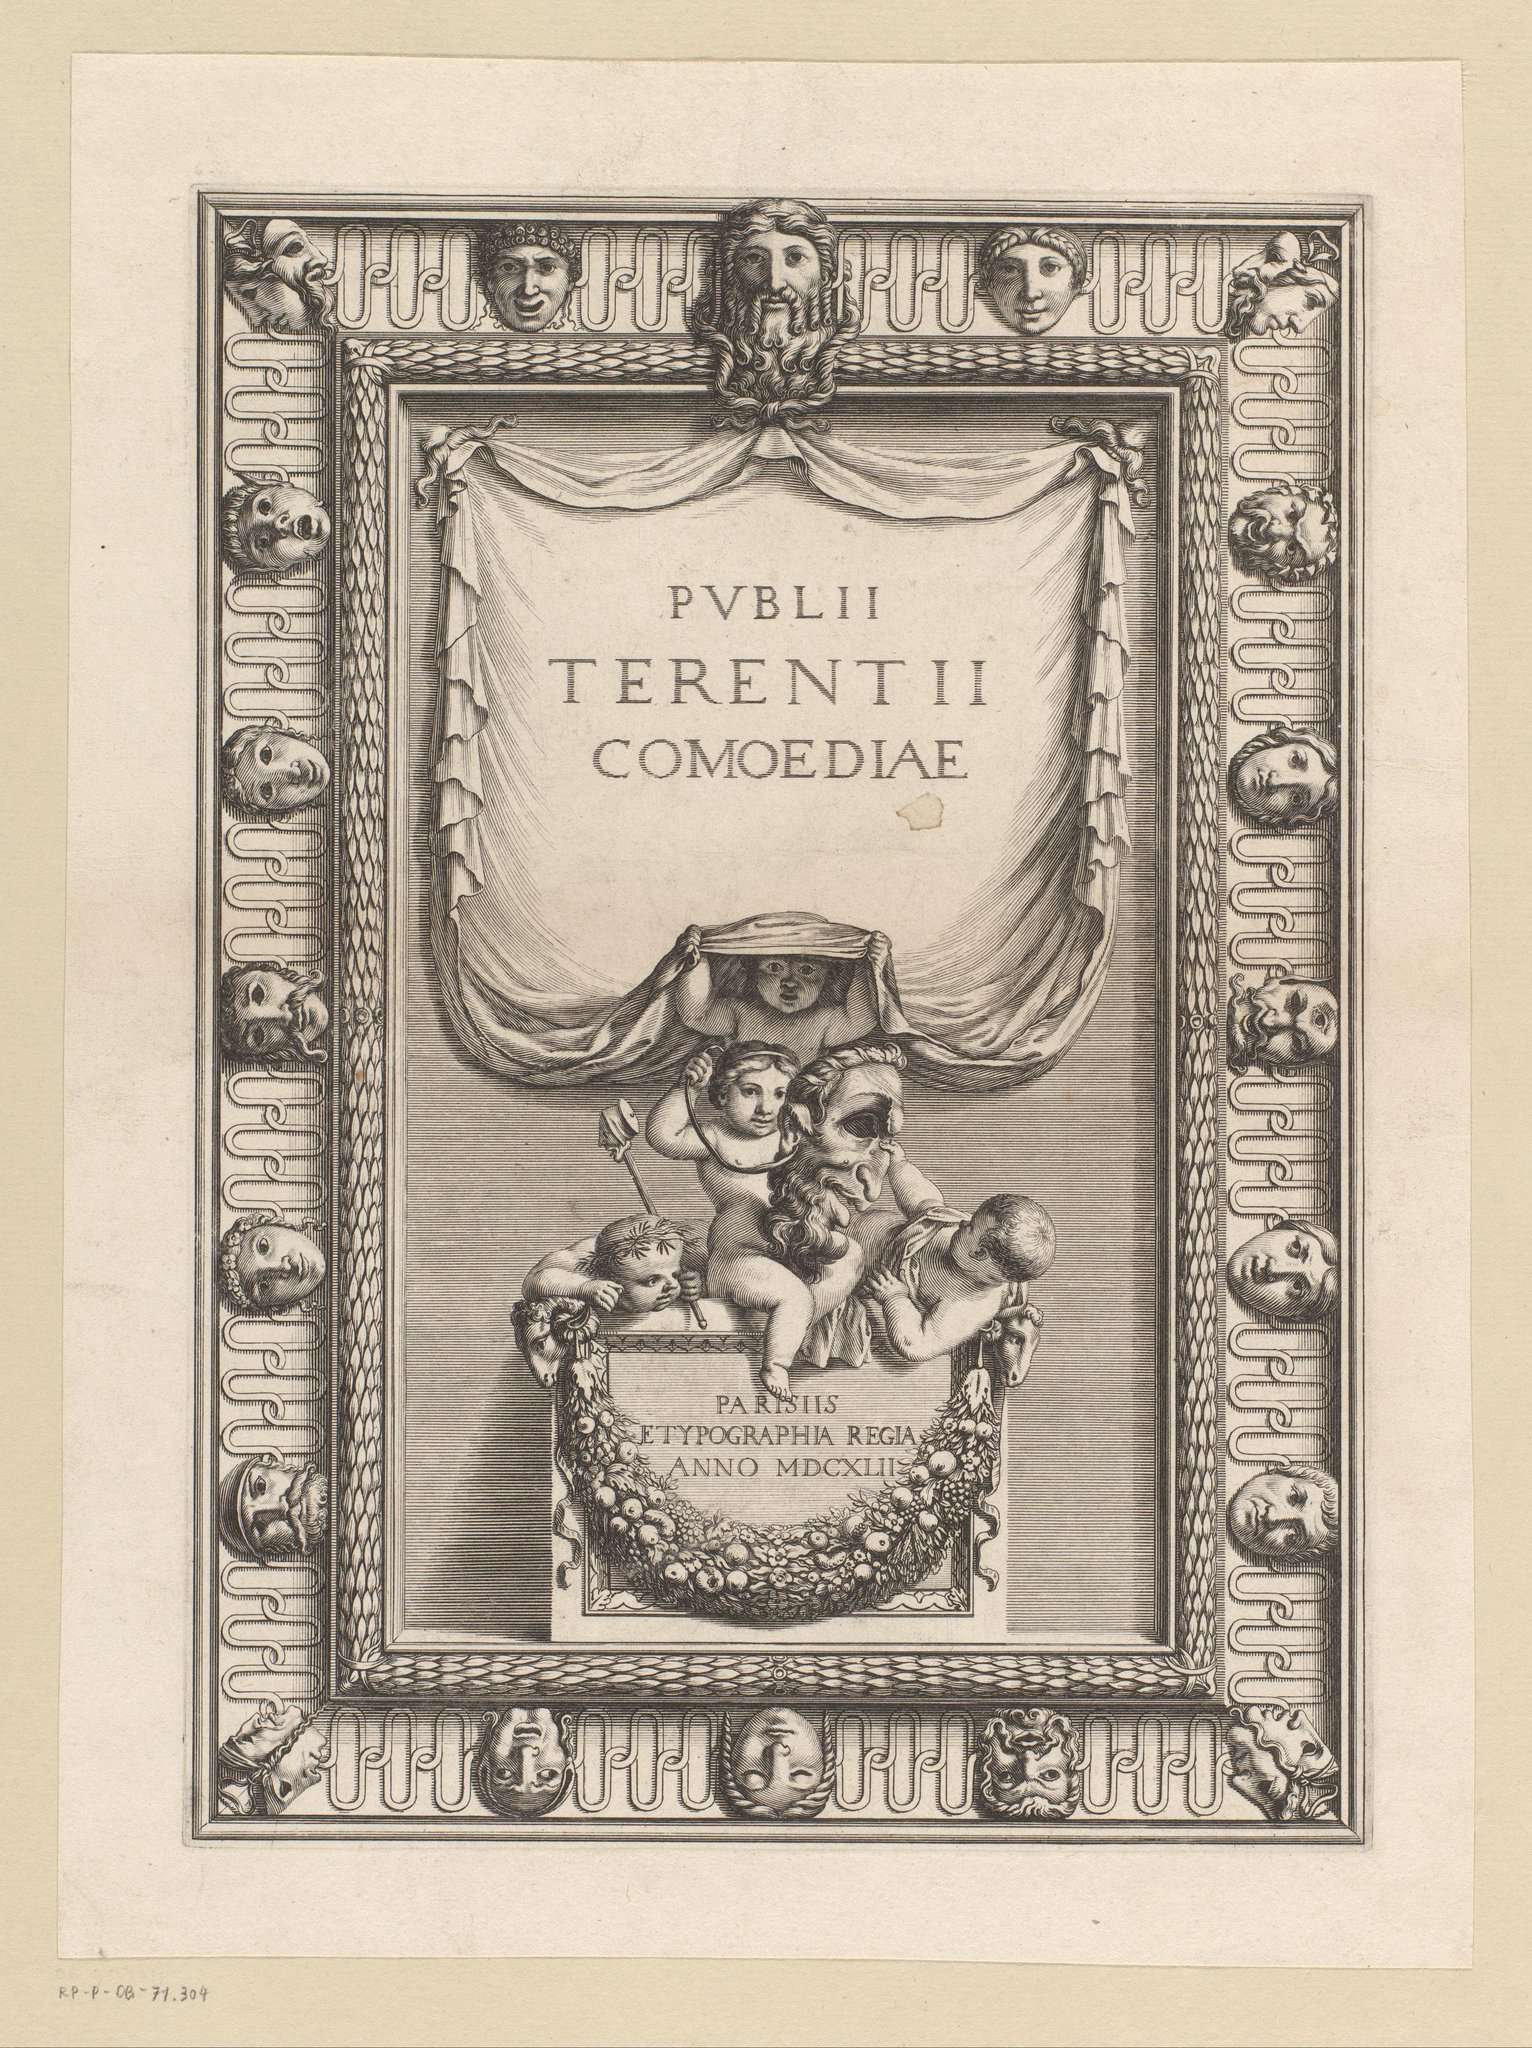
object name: titelblad, titelpagina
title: Lijst met maskers en vier putti spelend met een masker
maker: claude mellan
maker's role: draughtsman, print maker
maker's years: 1598-1688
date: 1642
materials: paper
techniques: engraving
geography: paris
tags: mask, cupids: 'amores', 'amoretti', 'putti'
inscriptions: collector's mark: Lugt 240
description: Titelpagina voor: Publii Terentii Comoediae. Parijs: Imprimerie Royale, 1642.